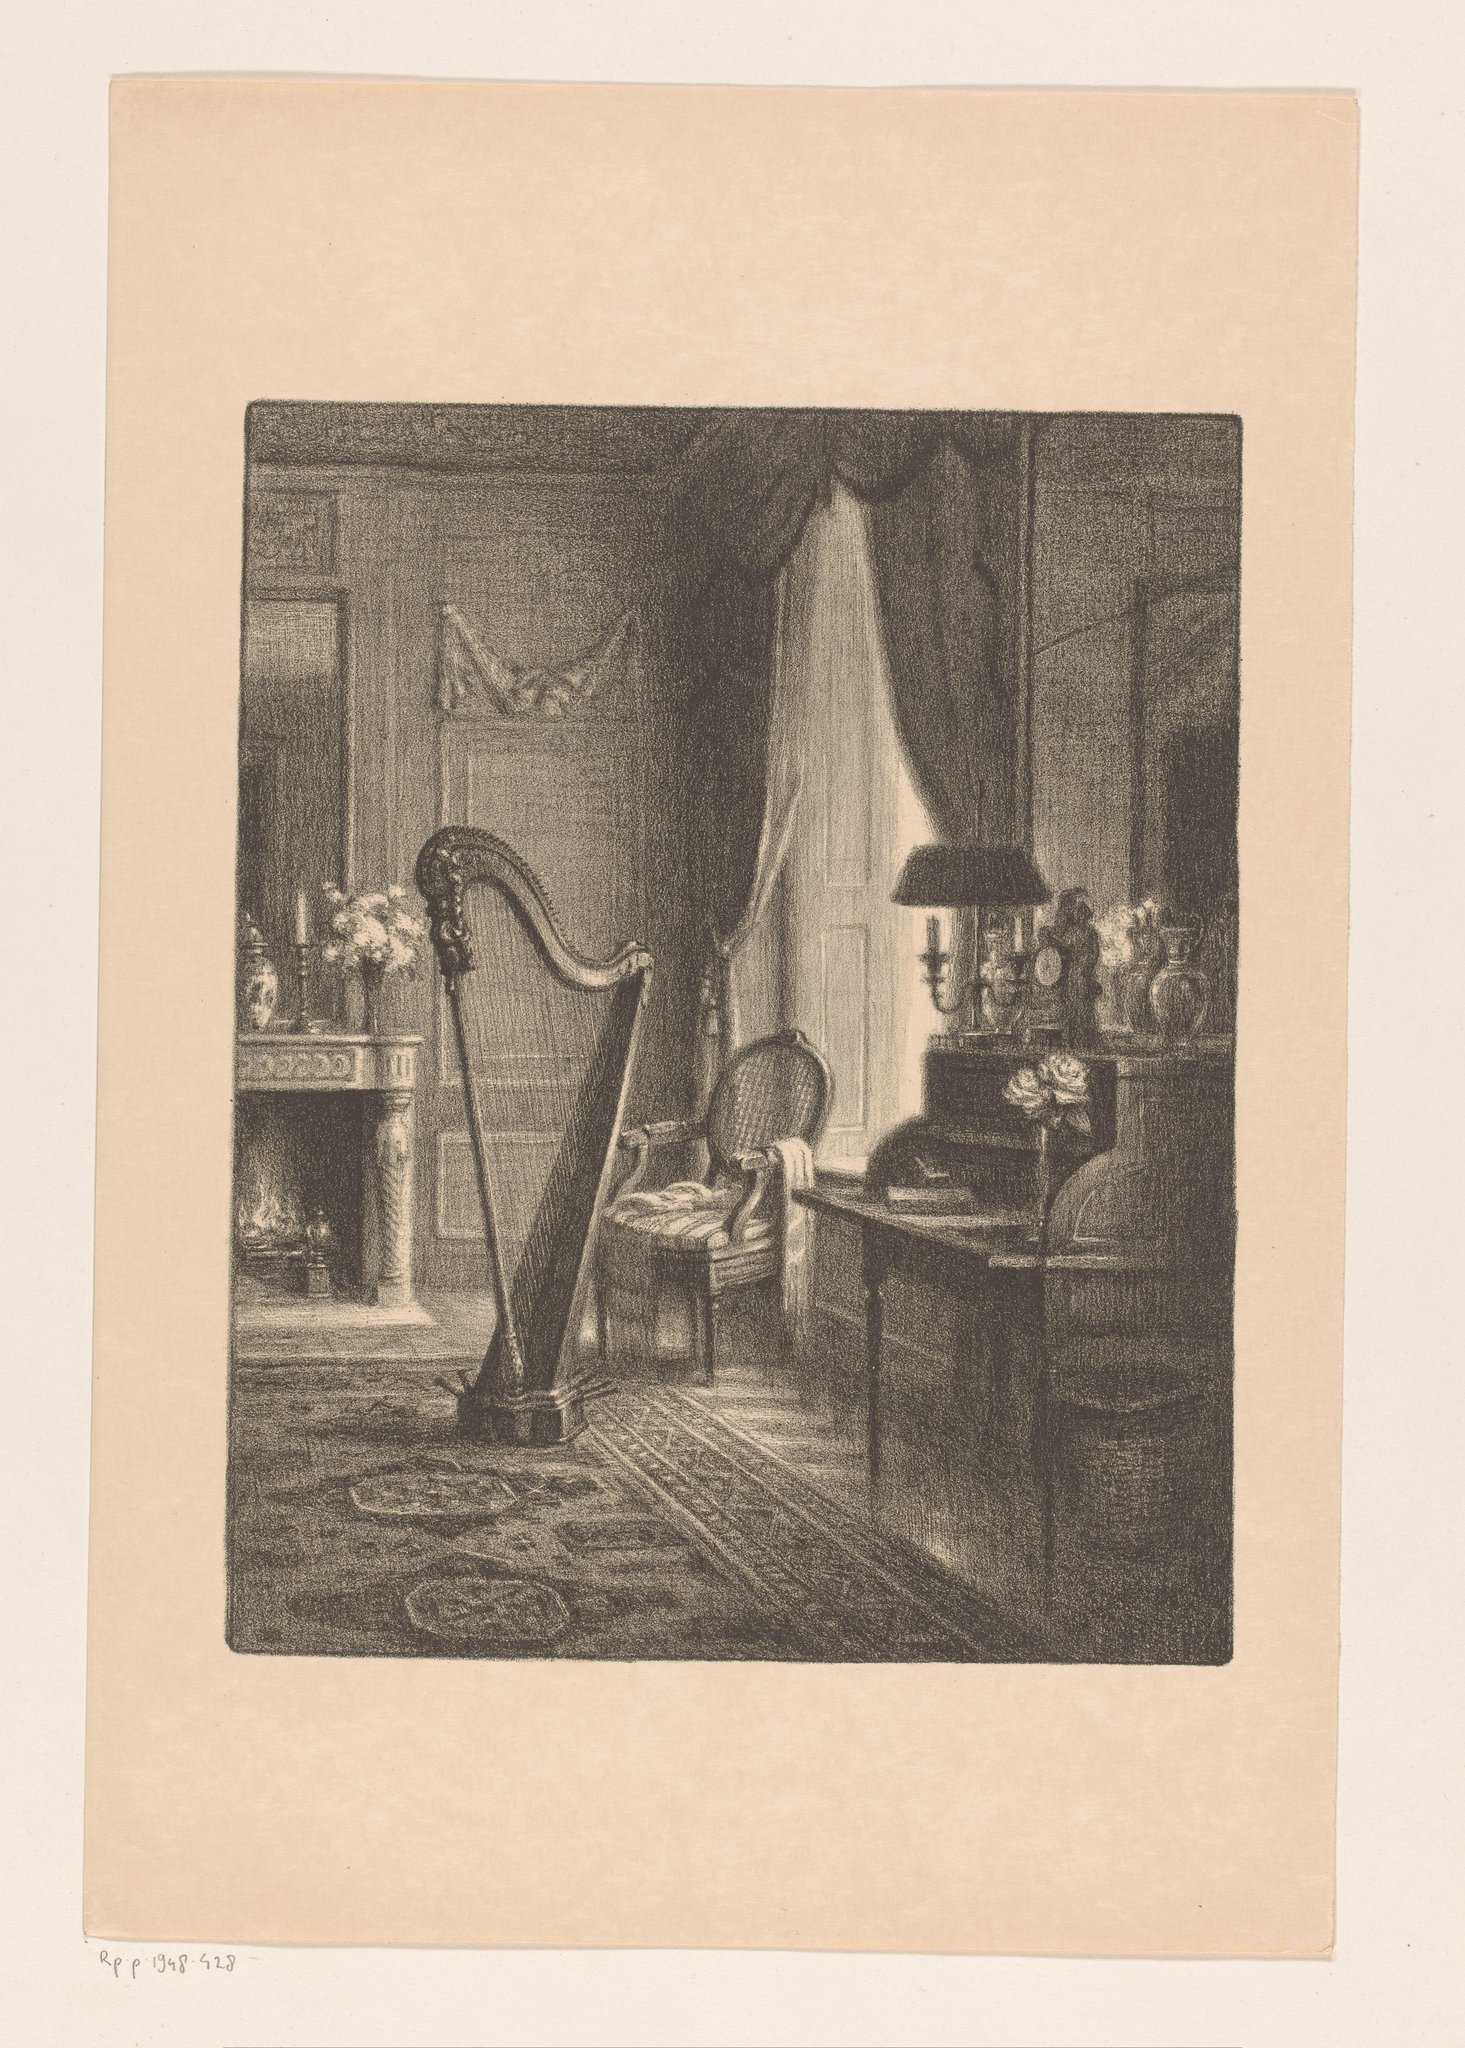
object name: print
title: Interieur met haard, secretaire en harp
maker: rené janssens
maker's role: draughtsman, print maker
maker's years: 1870-1936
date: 1880-1936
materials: paper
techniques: lithograph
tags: harp, interior of the house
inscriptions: collector's mark: Lugt 2228, workshop stamp: ‘Atelier René Janssens’